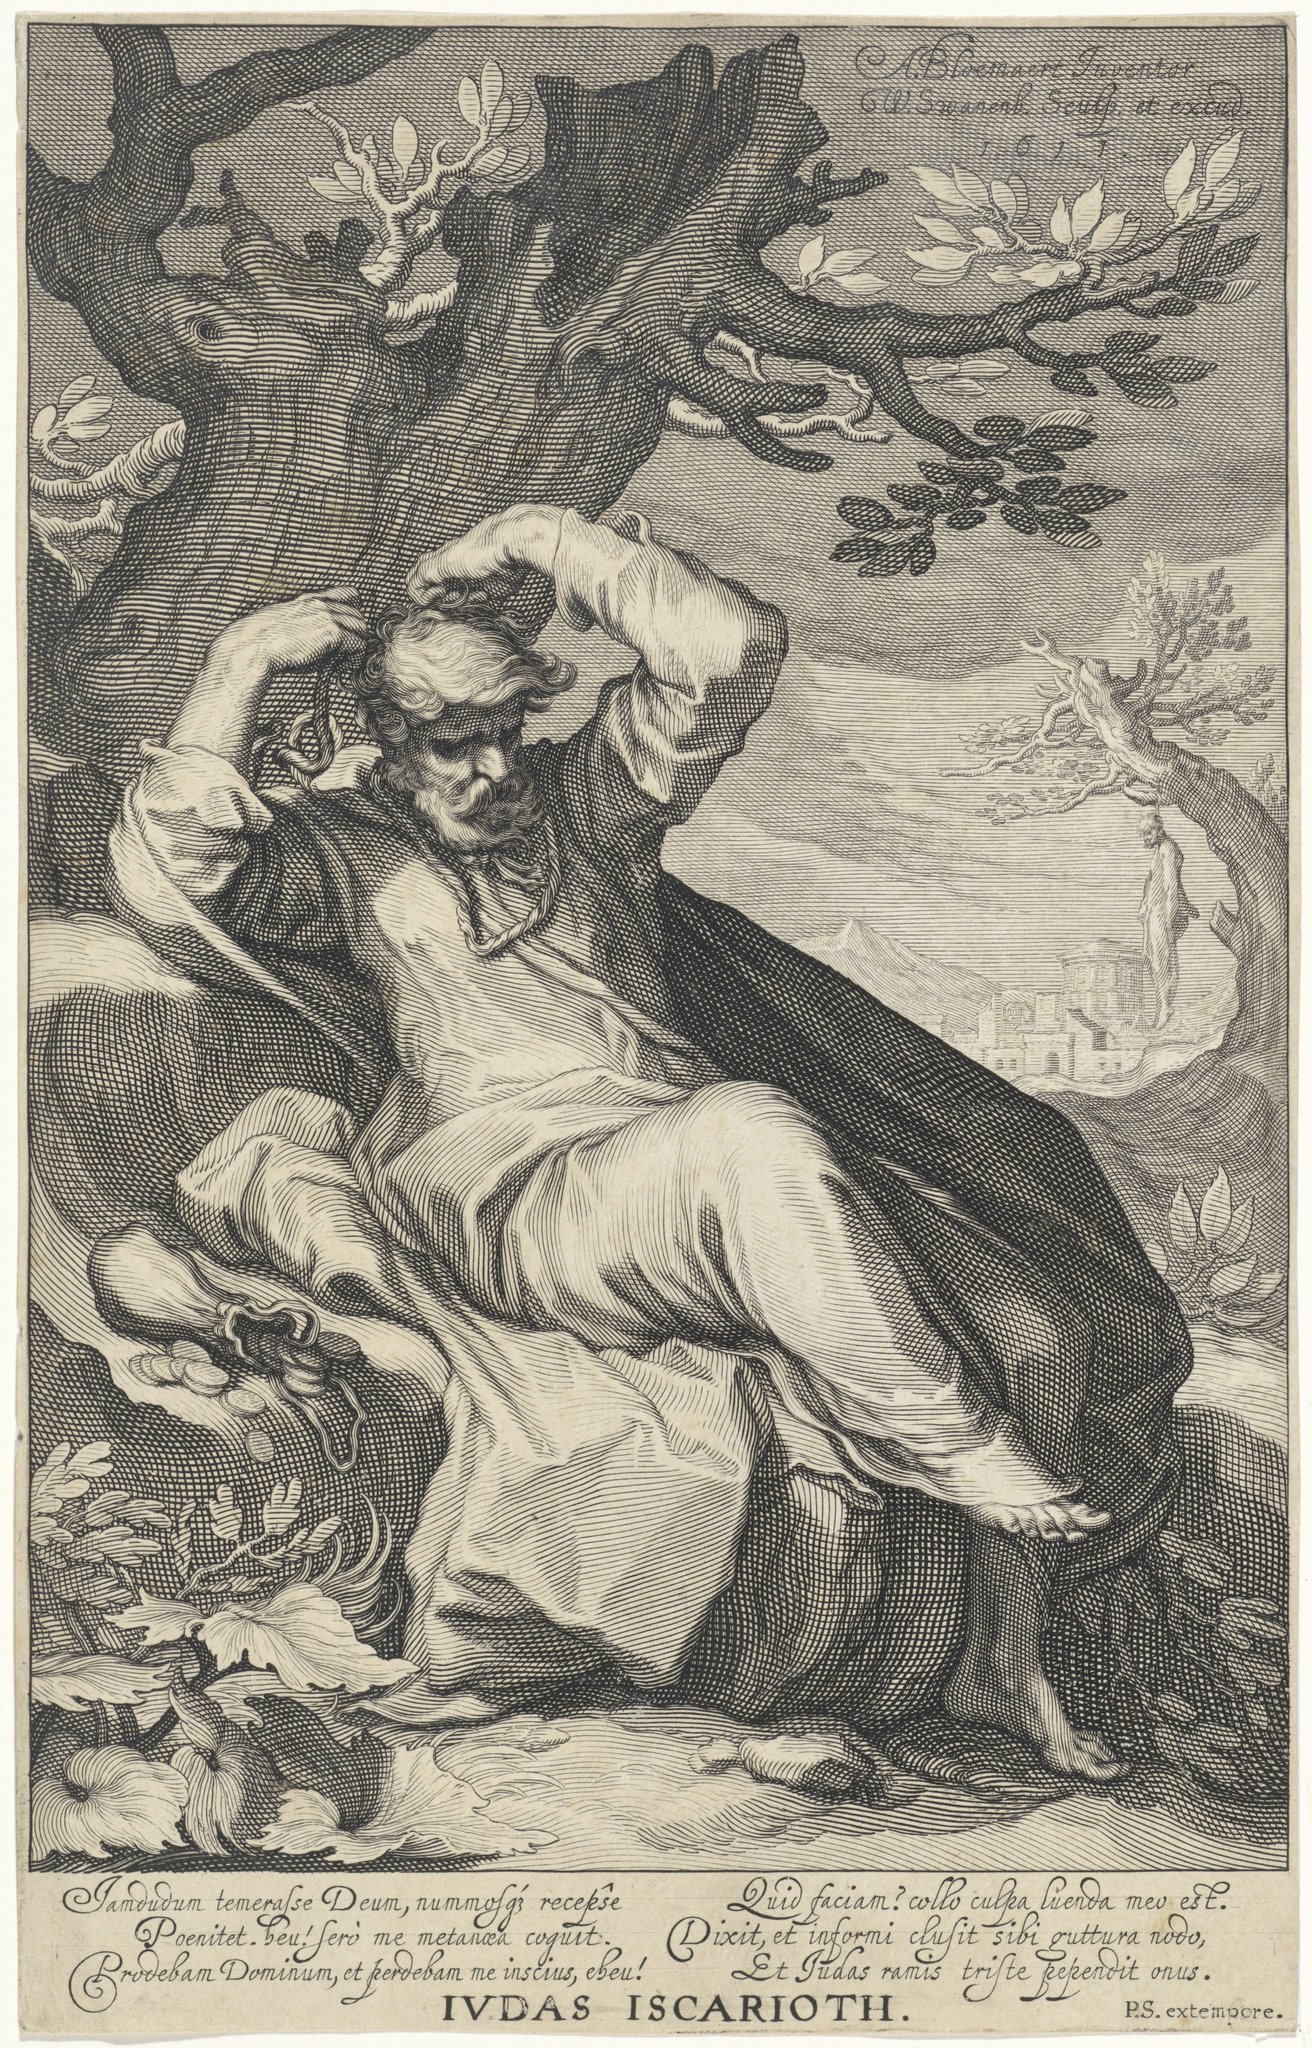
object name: print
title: Judas Iskariot hangt zich op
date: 1611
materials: paper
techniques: engraving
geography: leiden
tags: judas hanging himself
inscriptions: collector's mark: Lugt 240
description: Judas Iskariot zit onder een boom en knoopt een touw om zijn nek. Naast hem ligt een geldbuidel. Rechts in de verte hangt hij aan een boom. Onder de voorstelling bevindt zich een zesregelige, Latijnse tekst met een beschrijving van de scène.